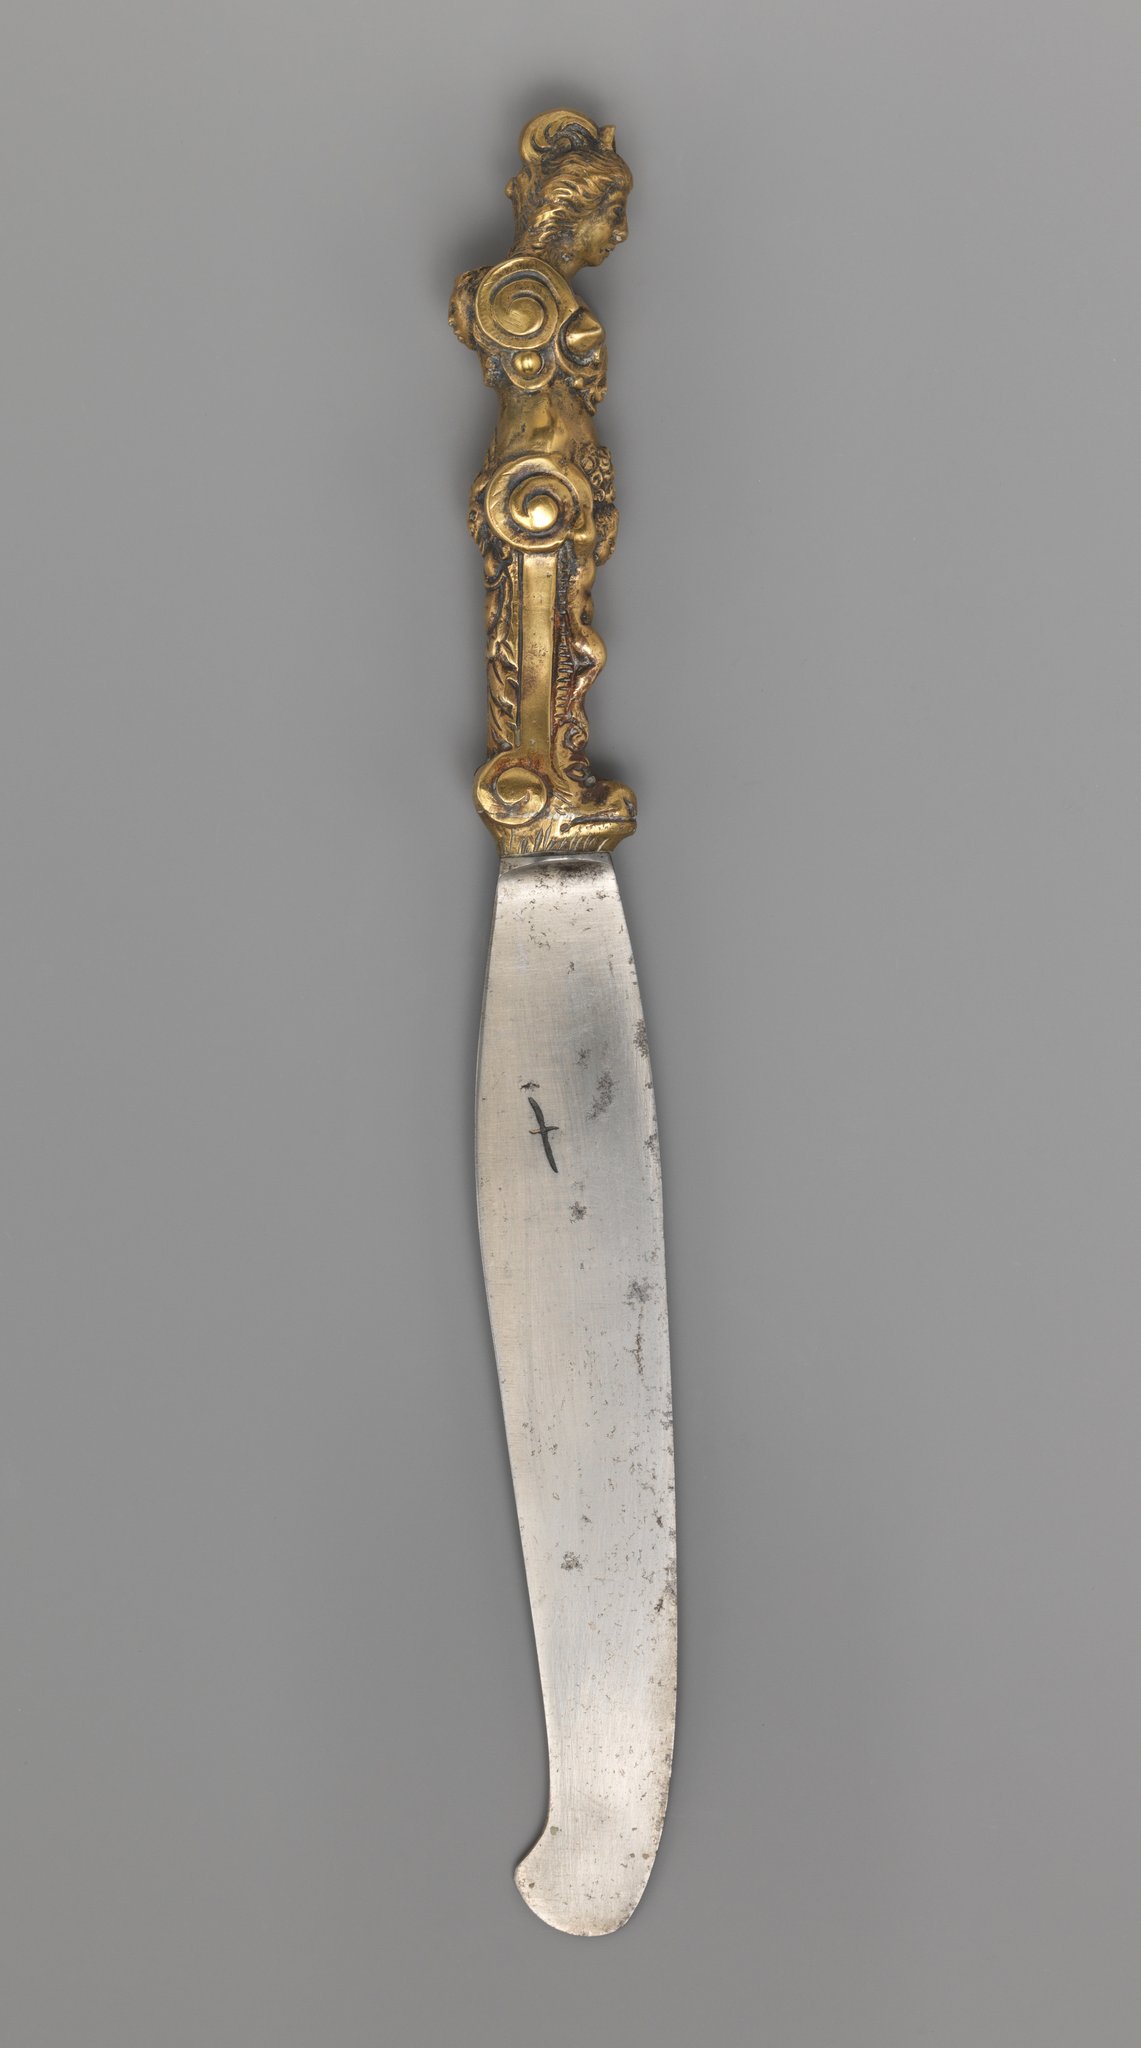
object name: table knife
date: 1667-1700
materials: bronze, steel